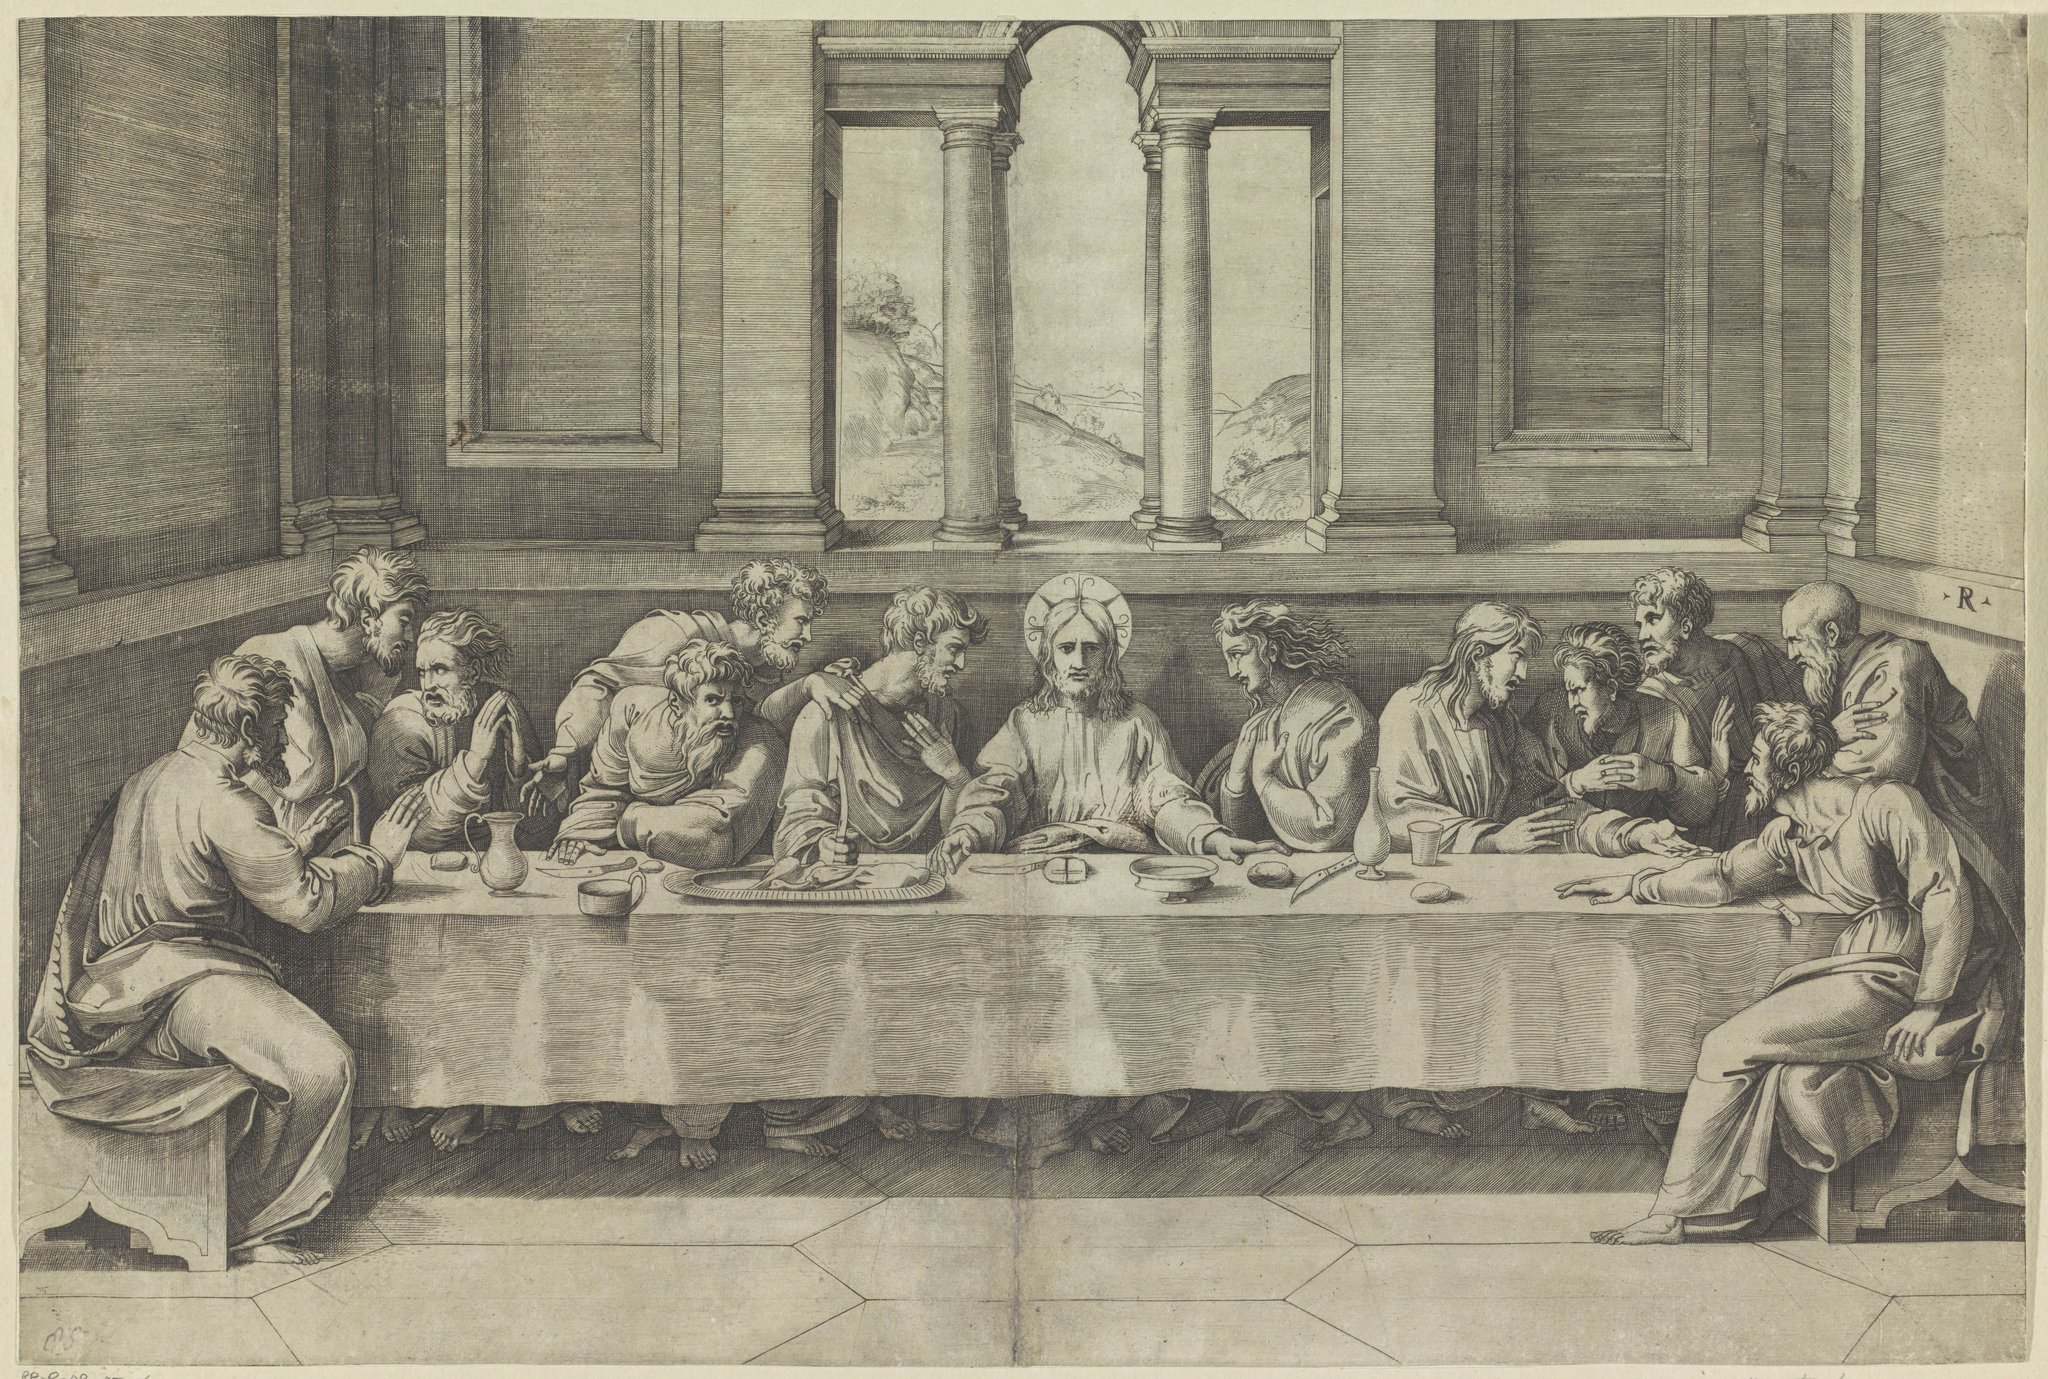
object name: print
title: Laatste Avondmaal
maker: marco dente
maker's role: print maker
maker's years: 1486-1527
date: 1498-1532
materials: paper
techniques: engraving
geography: italy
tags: last supper (in general) (matthew 26:21-35; mark 14:18-31; luke 22:3, 22:15-23; john 13:21-38)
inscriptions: collector's mark: Lugt 240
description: Christus en zijn twaalf discipelen zittend rond een tafel. Door een venster op de achtergrond zicht op een landschap.